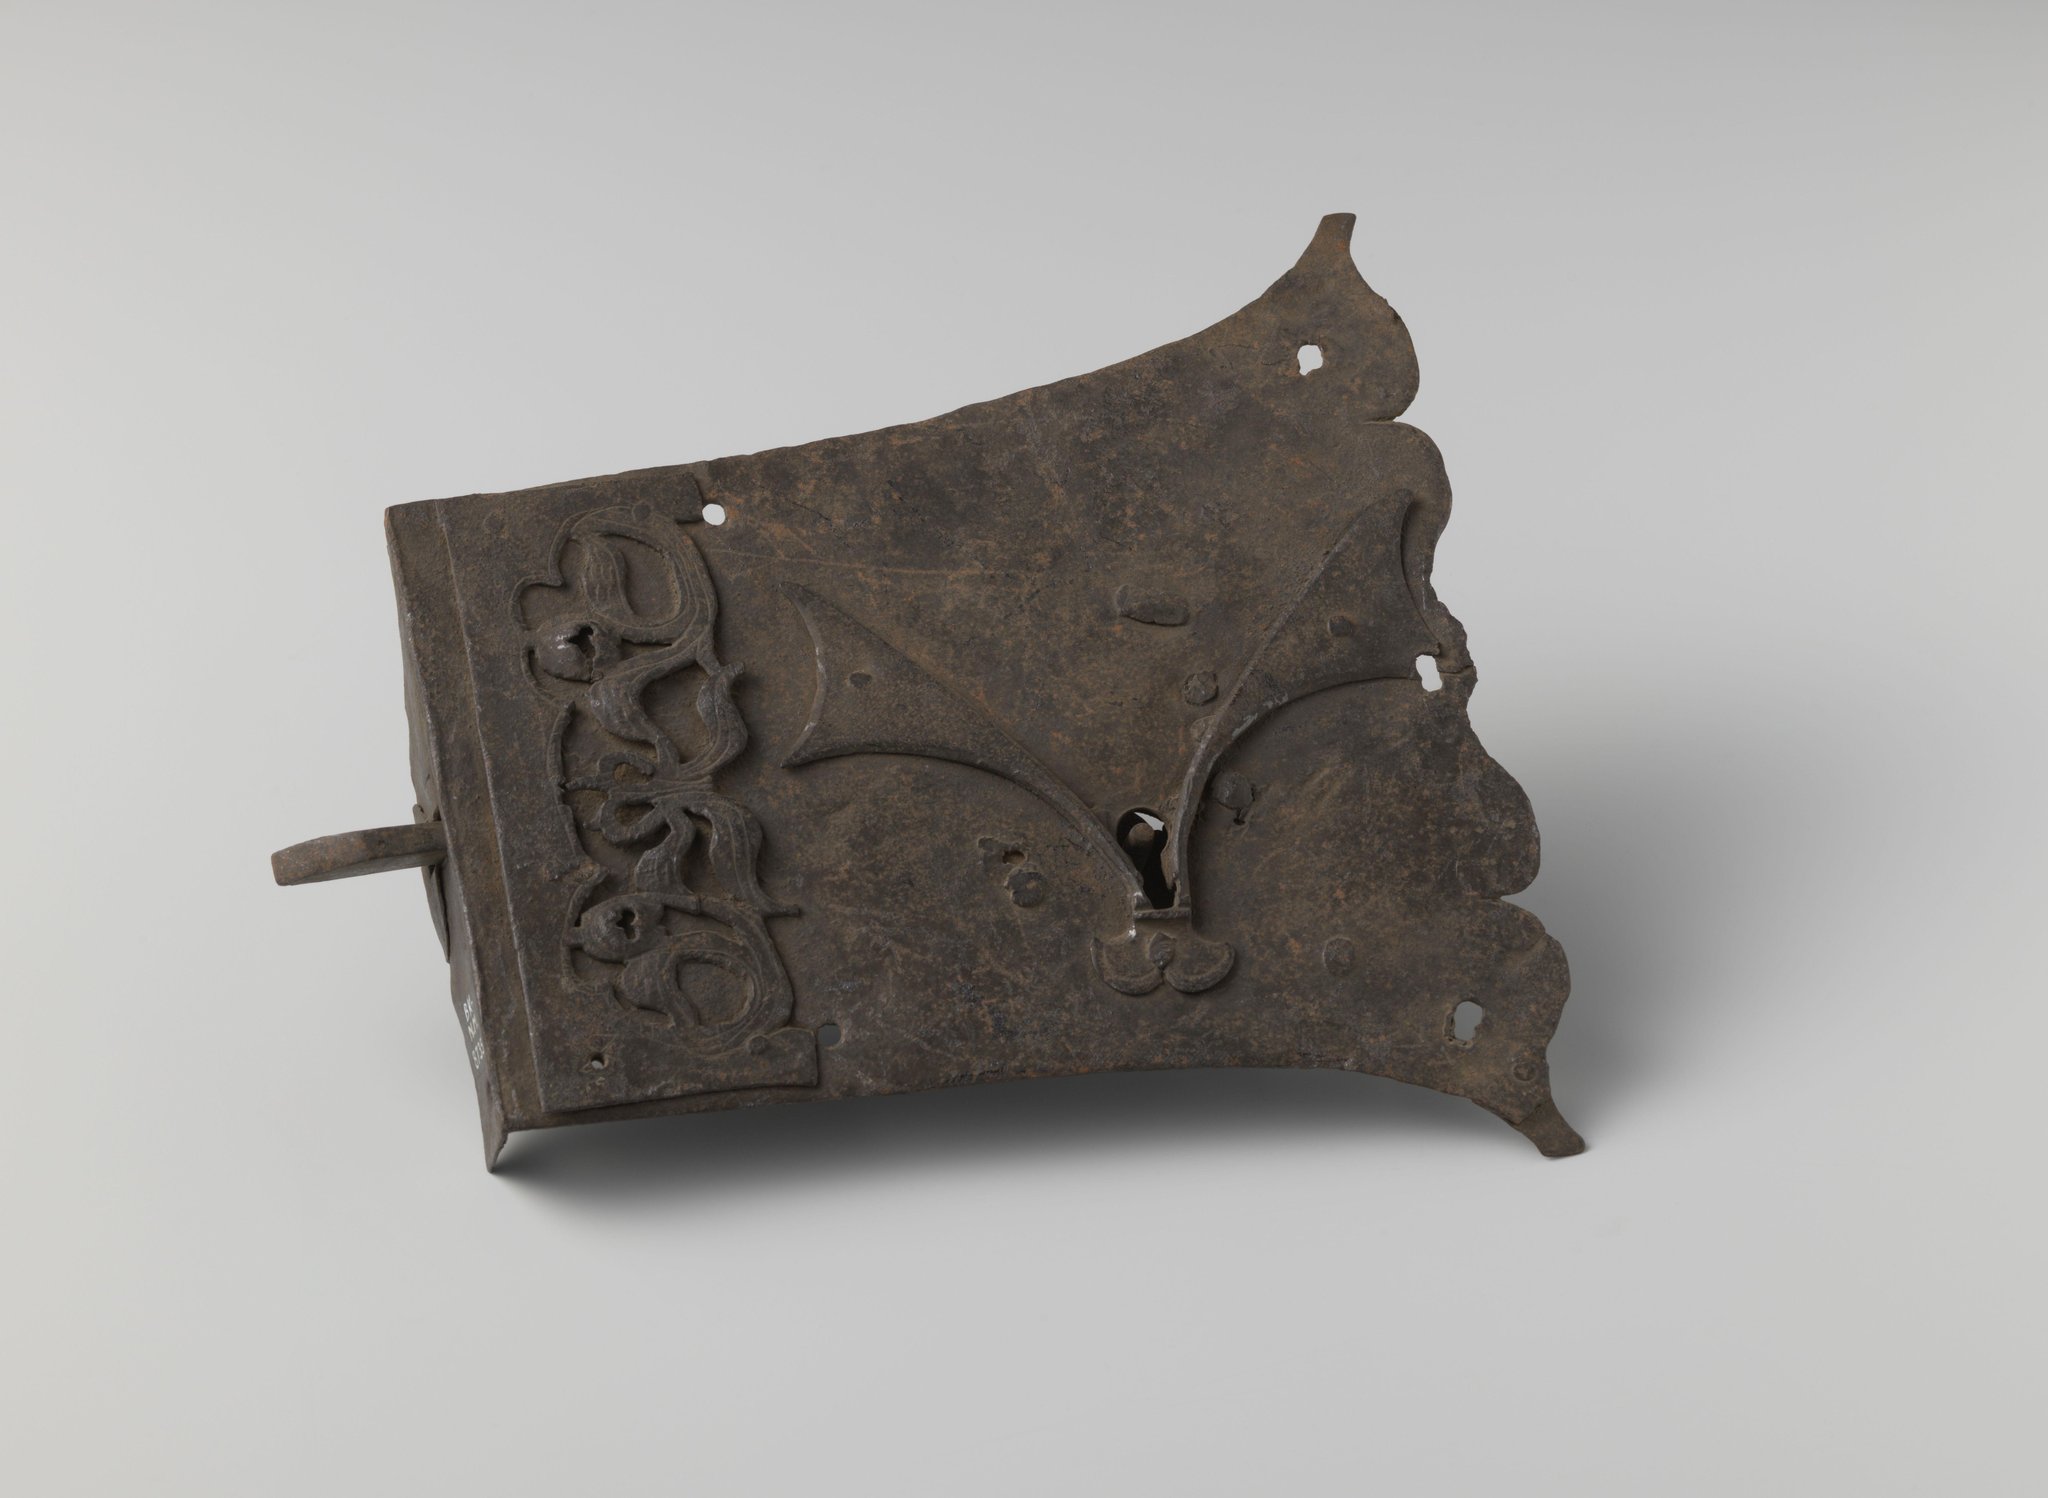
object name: lock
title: Slot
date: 1400-1499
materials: iron